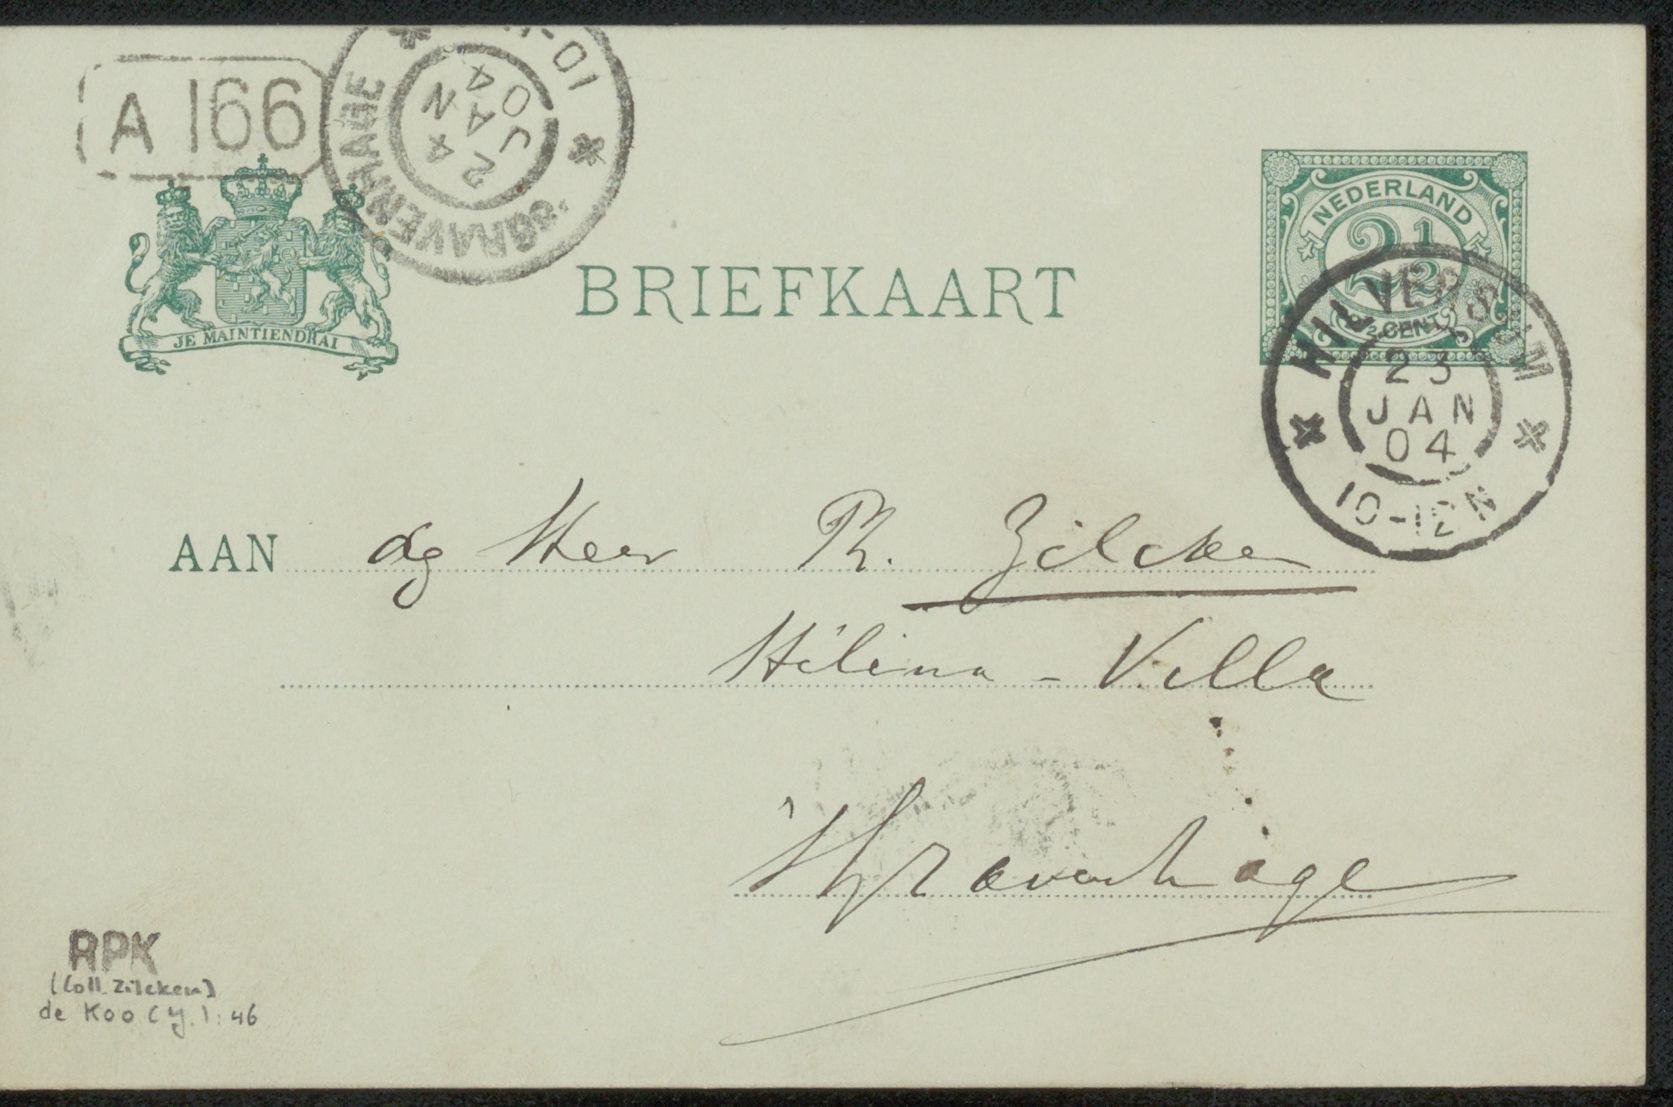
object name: postcard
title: Briefkaart aan Philip Zilcken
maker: johannes de koo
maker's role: auteur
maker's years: 1841-1909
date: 1904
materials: cardboard, ink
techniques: pen, writing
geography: hilversum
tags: the hague, painter, print maker, draughtsman, jozef israëls, philip zilcken, literature ~ arts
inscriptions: collector's mark: ‘RPK’